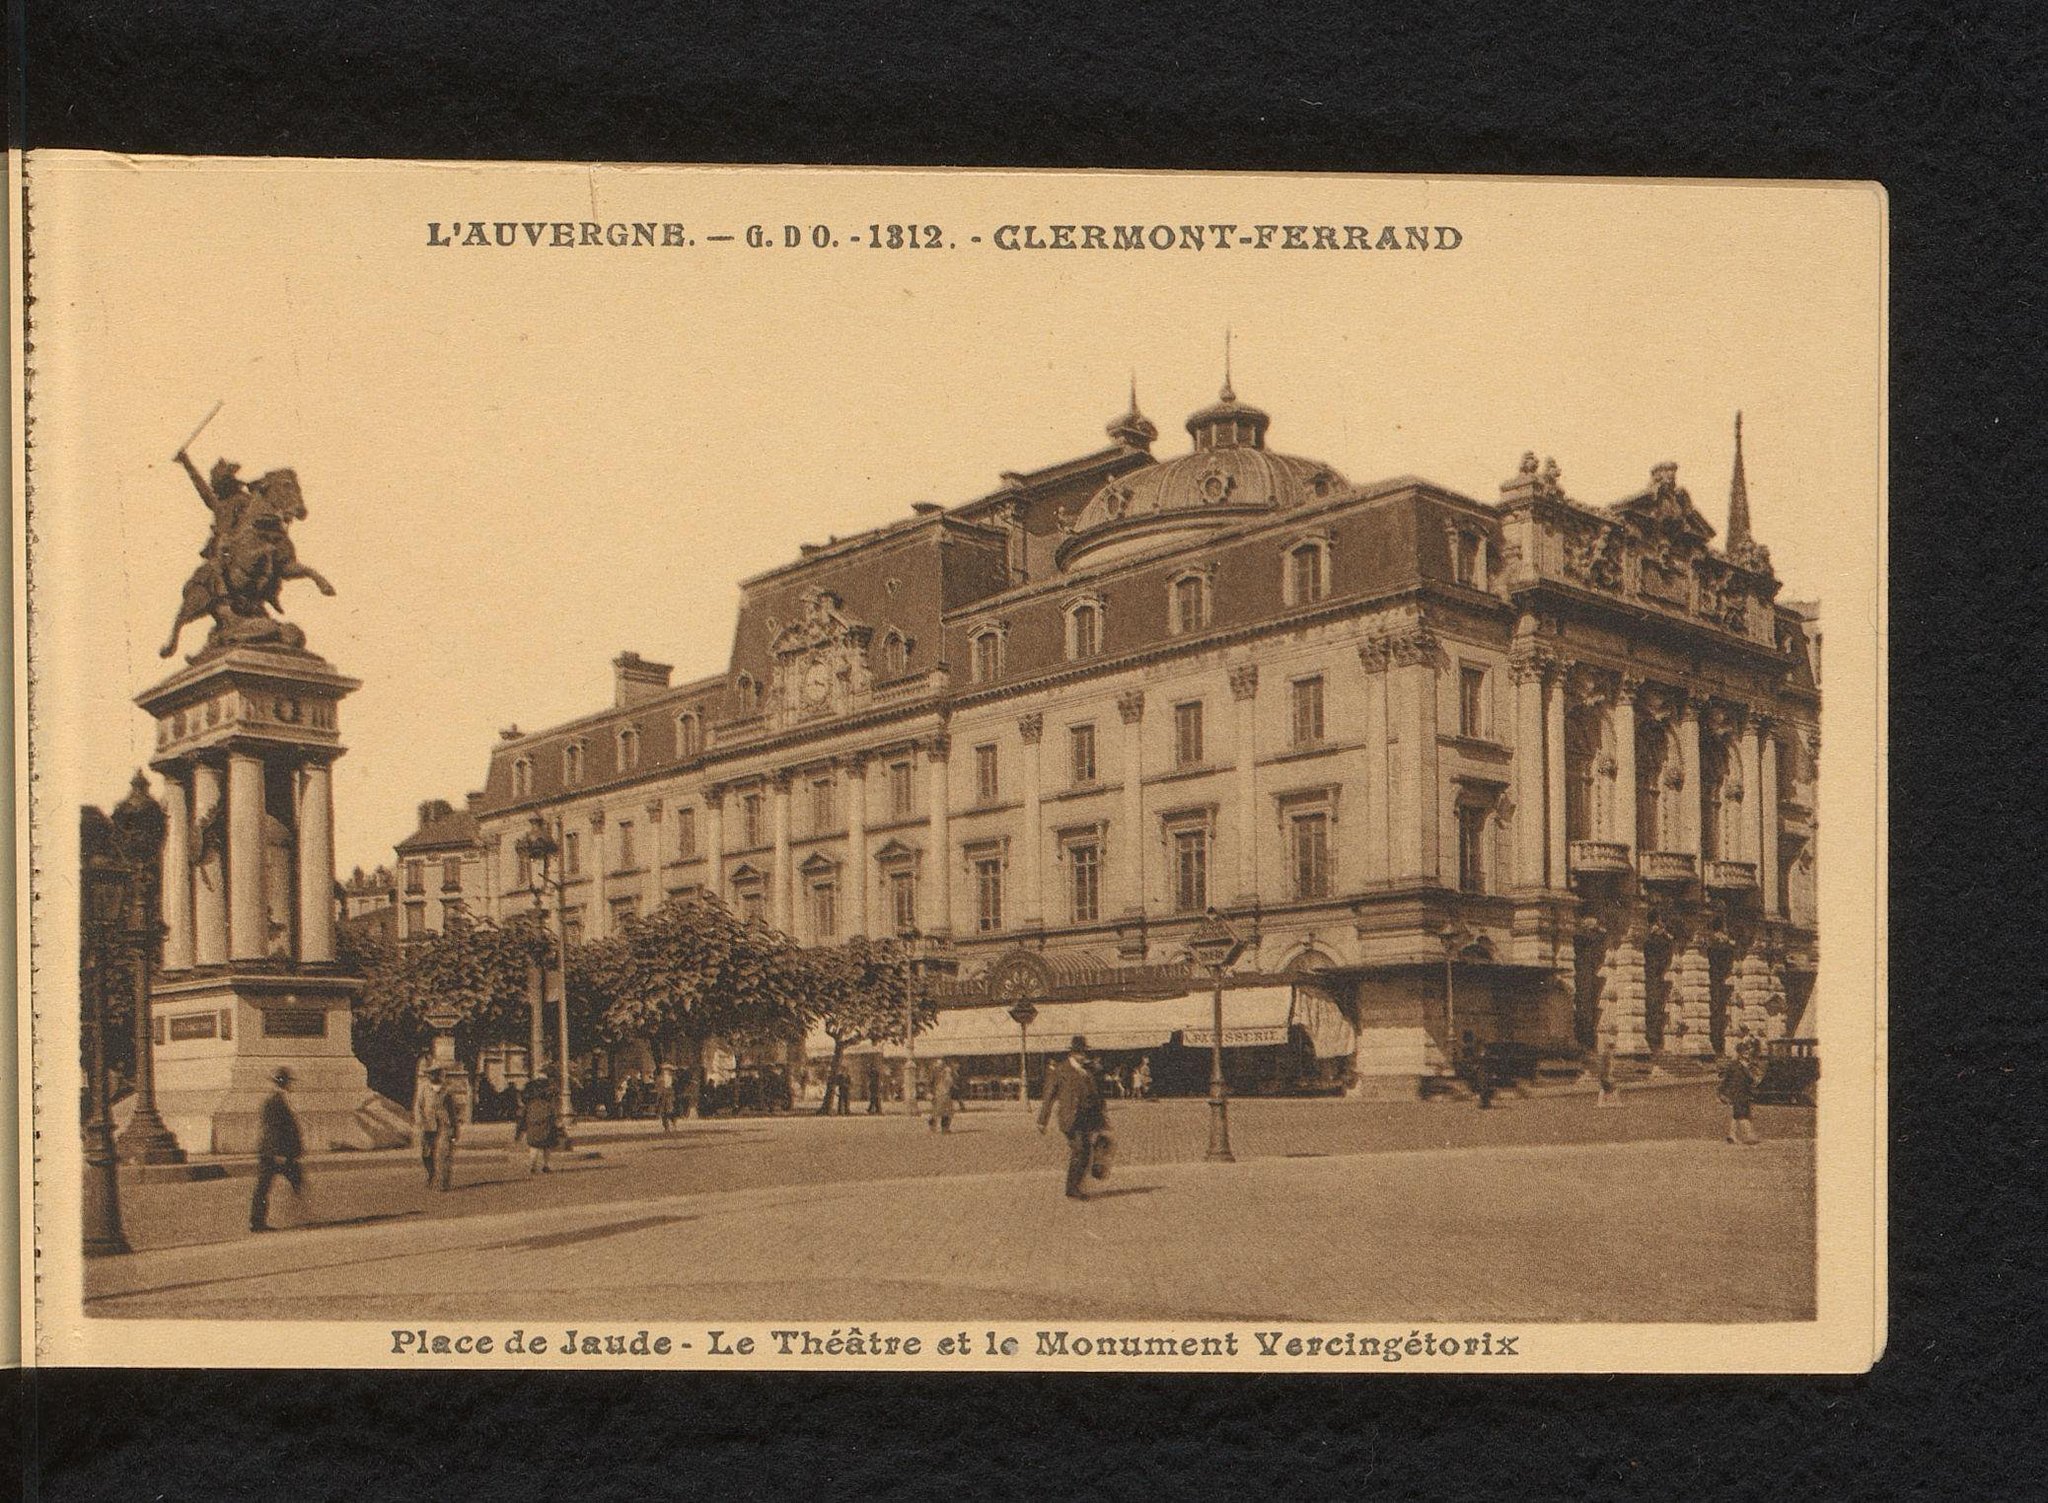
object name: photomechanical print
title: L'Auvergne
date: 1921-1930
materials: cardboard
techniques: photograph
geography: clermont-ferrand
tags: theatre (building), monument, statue, square, place, circus, etc. (+ city(-scape) with figures, staffage)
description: Prentbriefkaart maakt deel uit van een album.